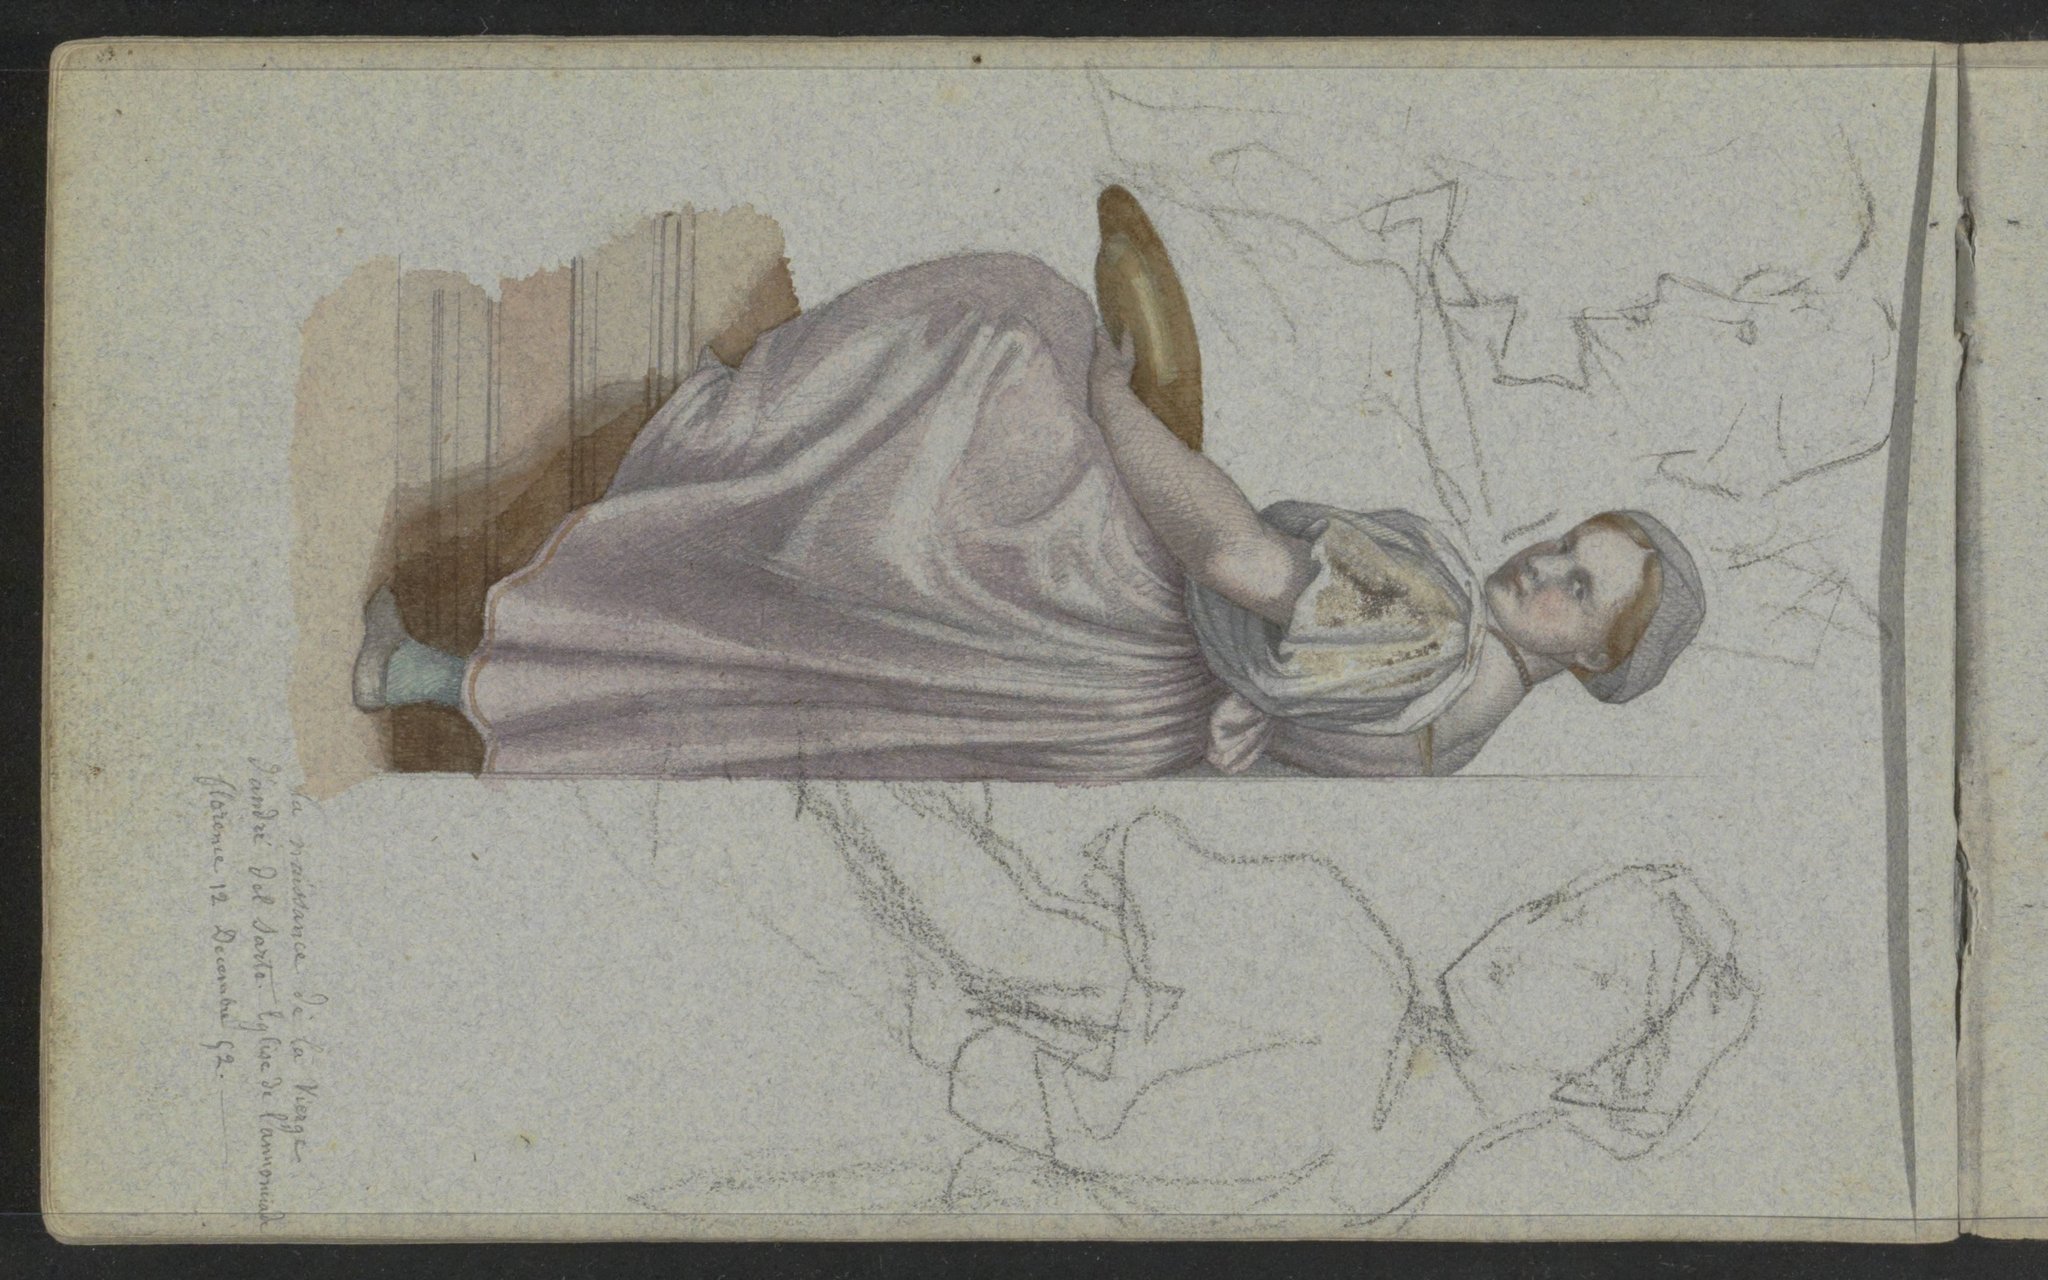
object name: sketchbook leaf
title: Kopie naar een detail van 'De geboorte van de maagd' van Andrea del Sarto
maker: matthijs maris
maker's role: draughtsman, painter, print maker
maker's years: 1839-1917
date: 1852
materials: chalk, paper, pencil, watercolor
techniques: brush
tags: standing figure (+ female (human being) (not to be used where -aa- is prescribed)), dish, plate, saucer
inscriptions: date and inscription: ‘La nuissance de la Vierge/ d'andre del Sarto Eglise de l'annonciade/ florence 12 December 52.’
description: Maris heeft de dienstmaagd rechts op het schilderij gekopieerd. Blad 35 verso uit een schetsboek met 35 bladen.